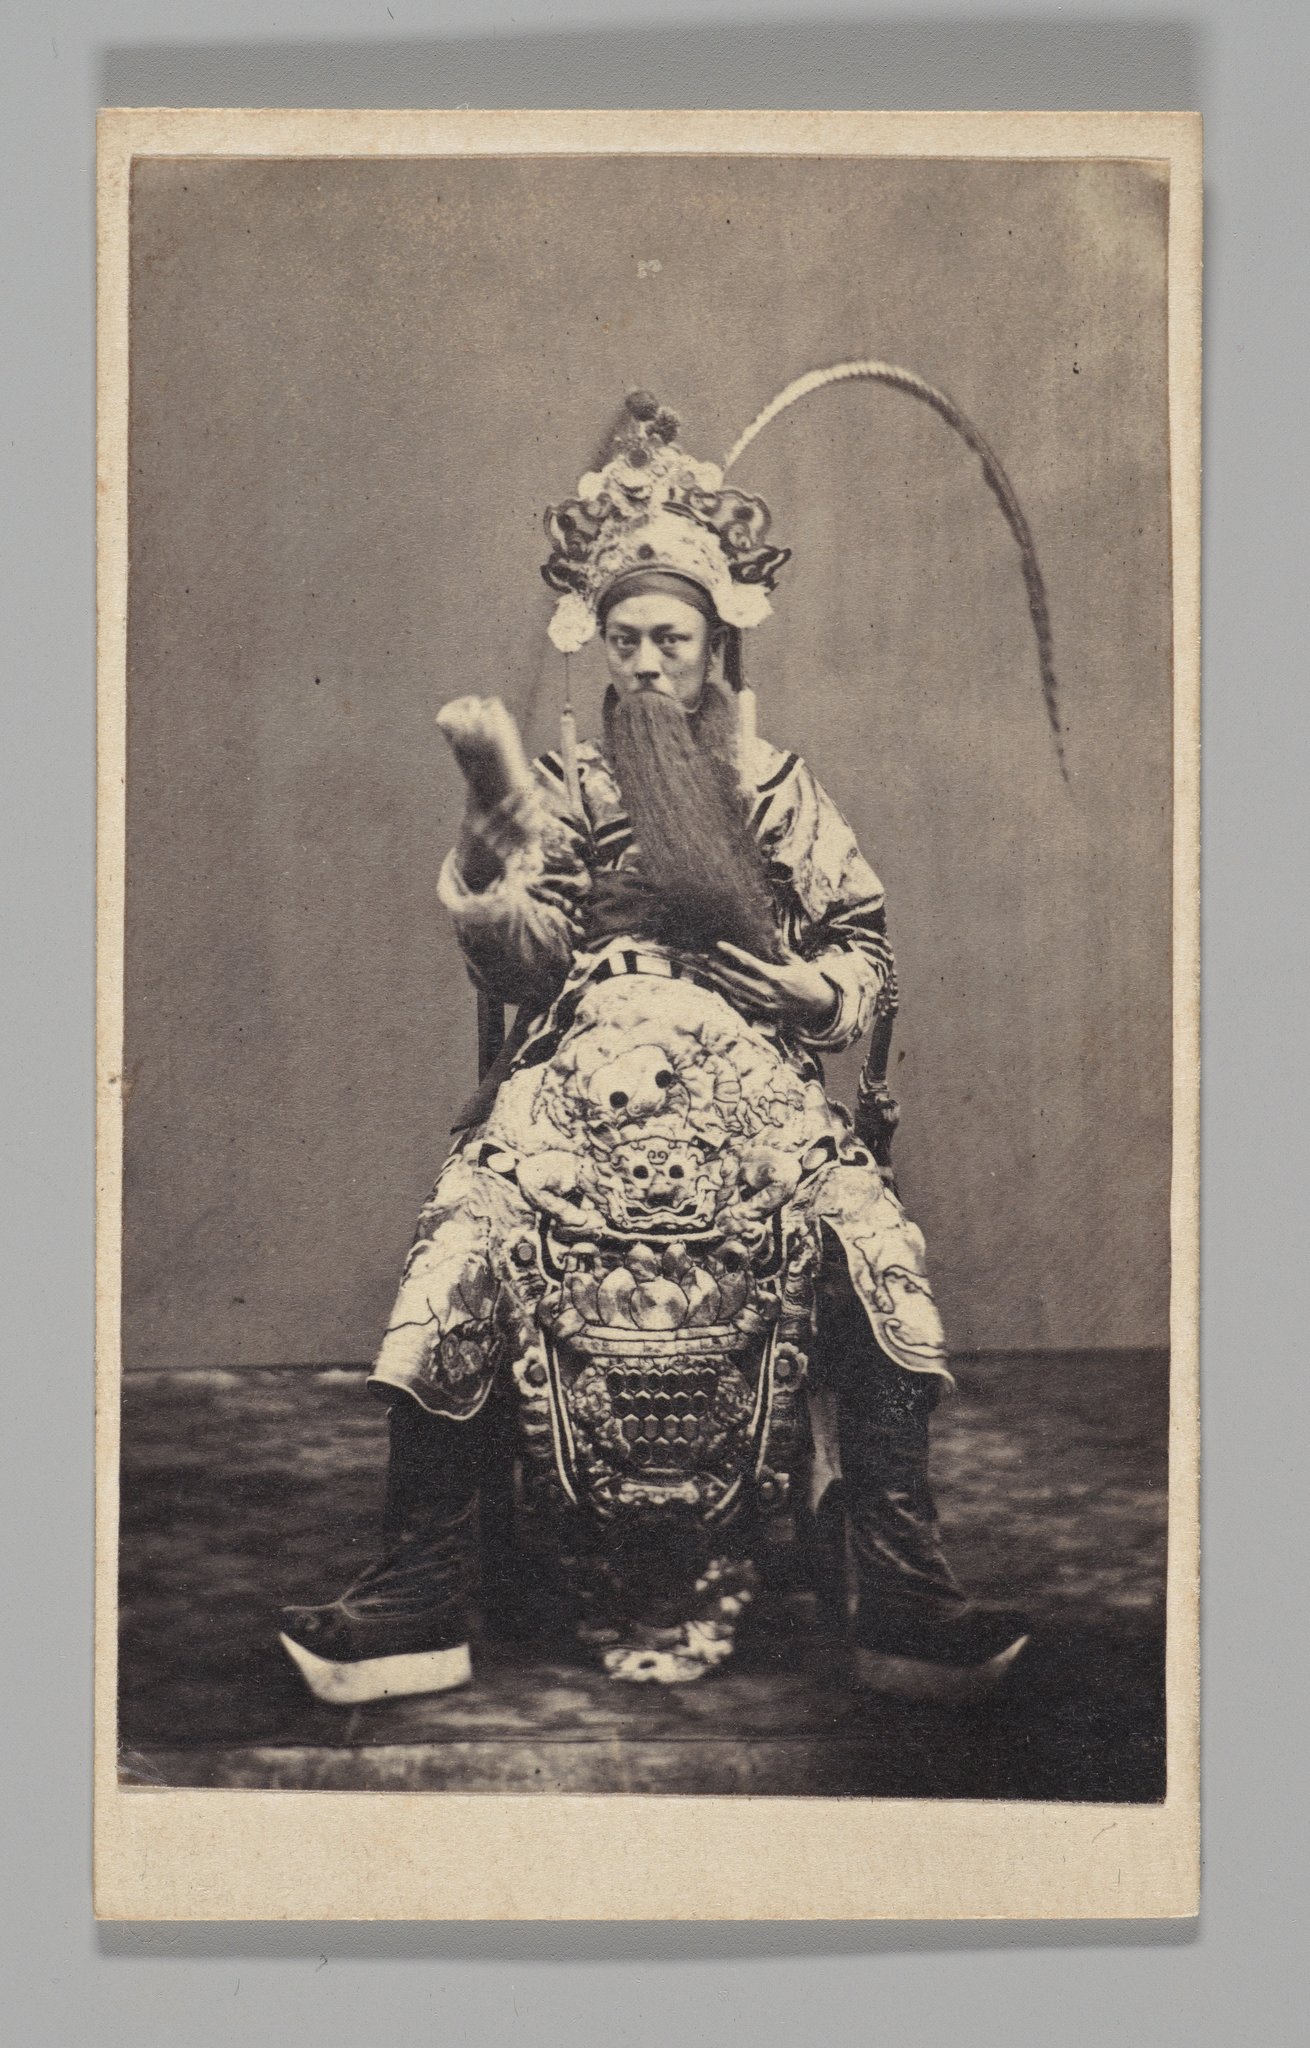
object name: carte de visite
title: [Studio Portrait: Actor in Costume Wearing Long Beard, Japan]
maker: Anonymous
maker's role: artist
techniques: albumen silver print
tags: men,portraits